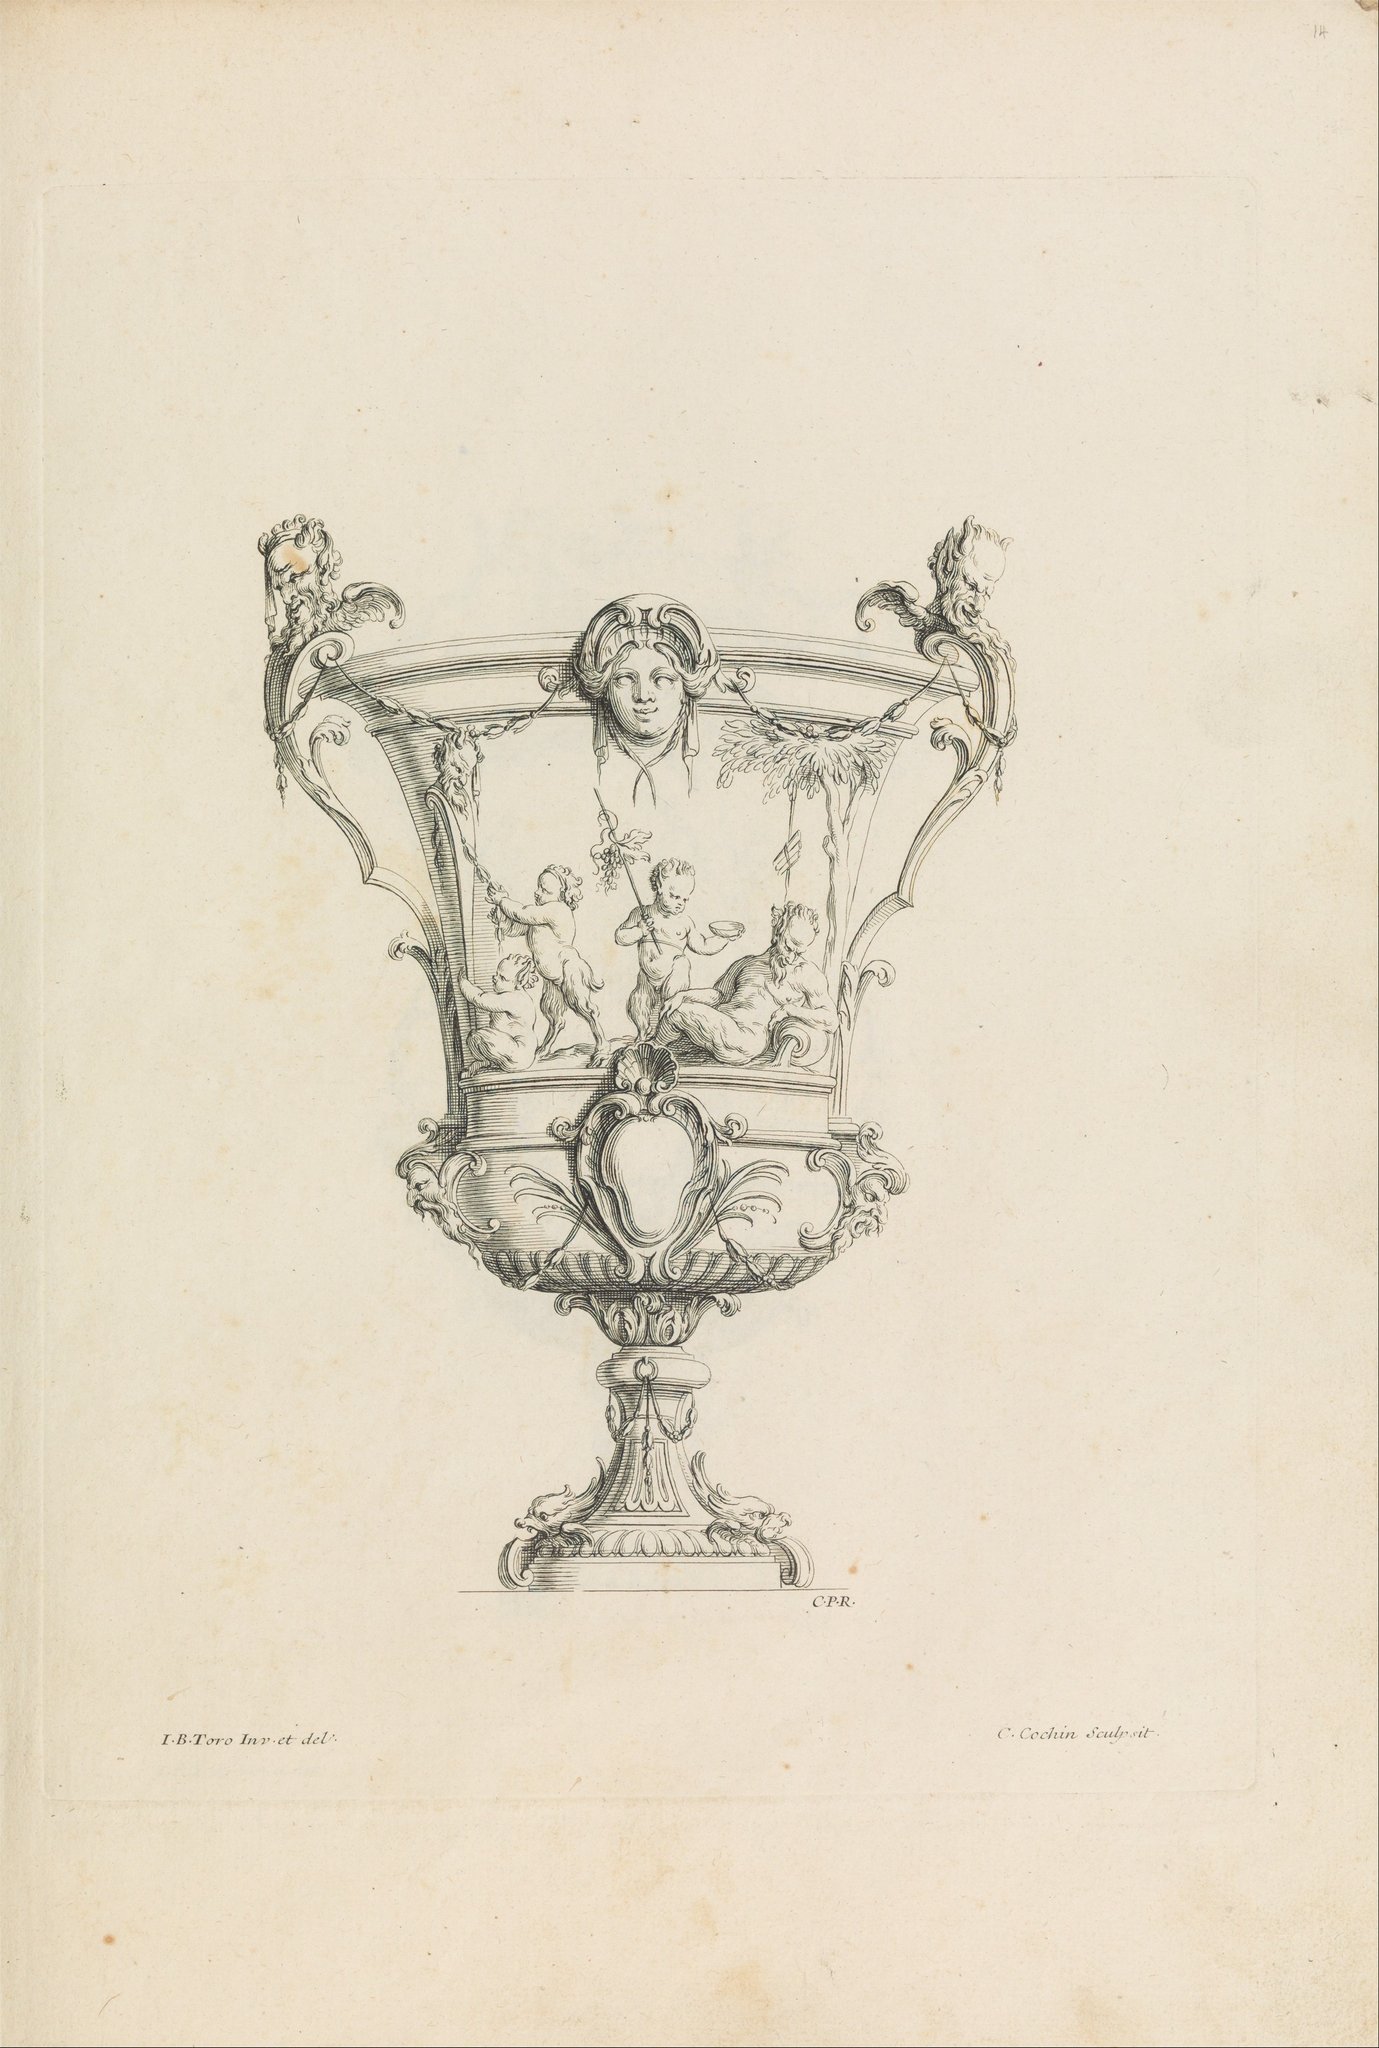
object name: album print ornament architecture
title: Nouveau Livre de Vases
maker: jean bernard toro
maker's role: designer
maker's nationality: french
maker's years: 1672-1731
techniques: etching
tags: heads,vases